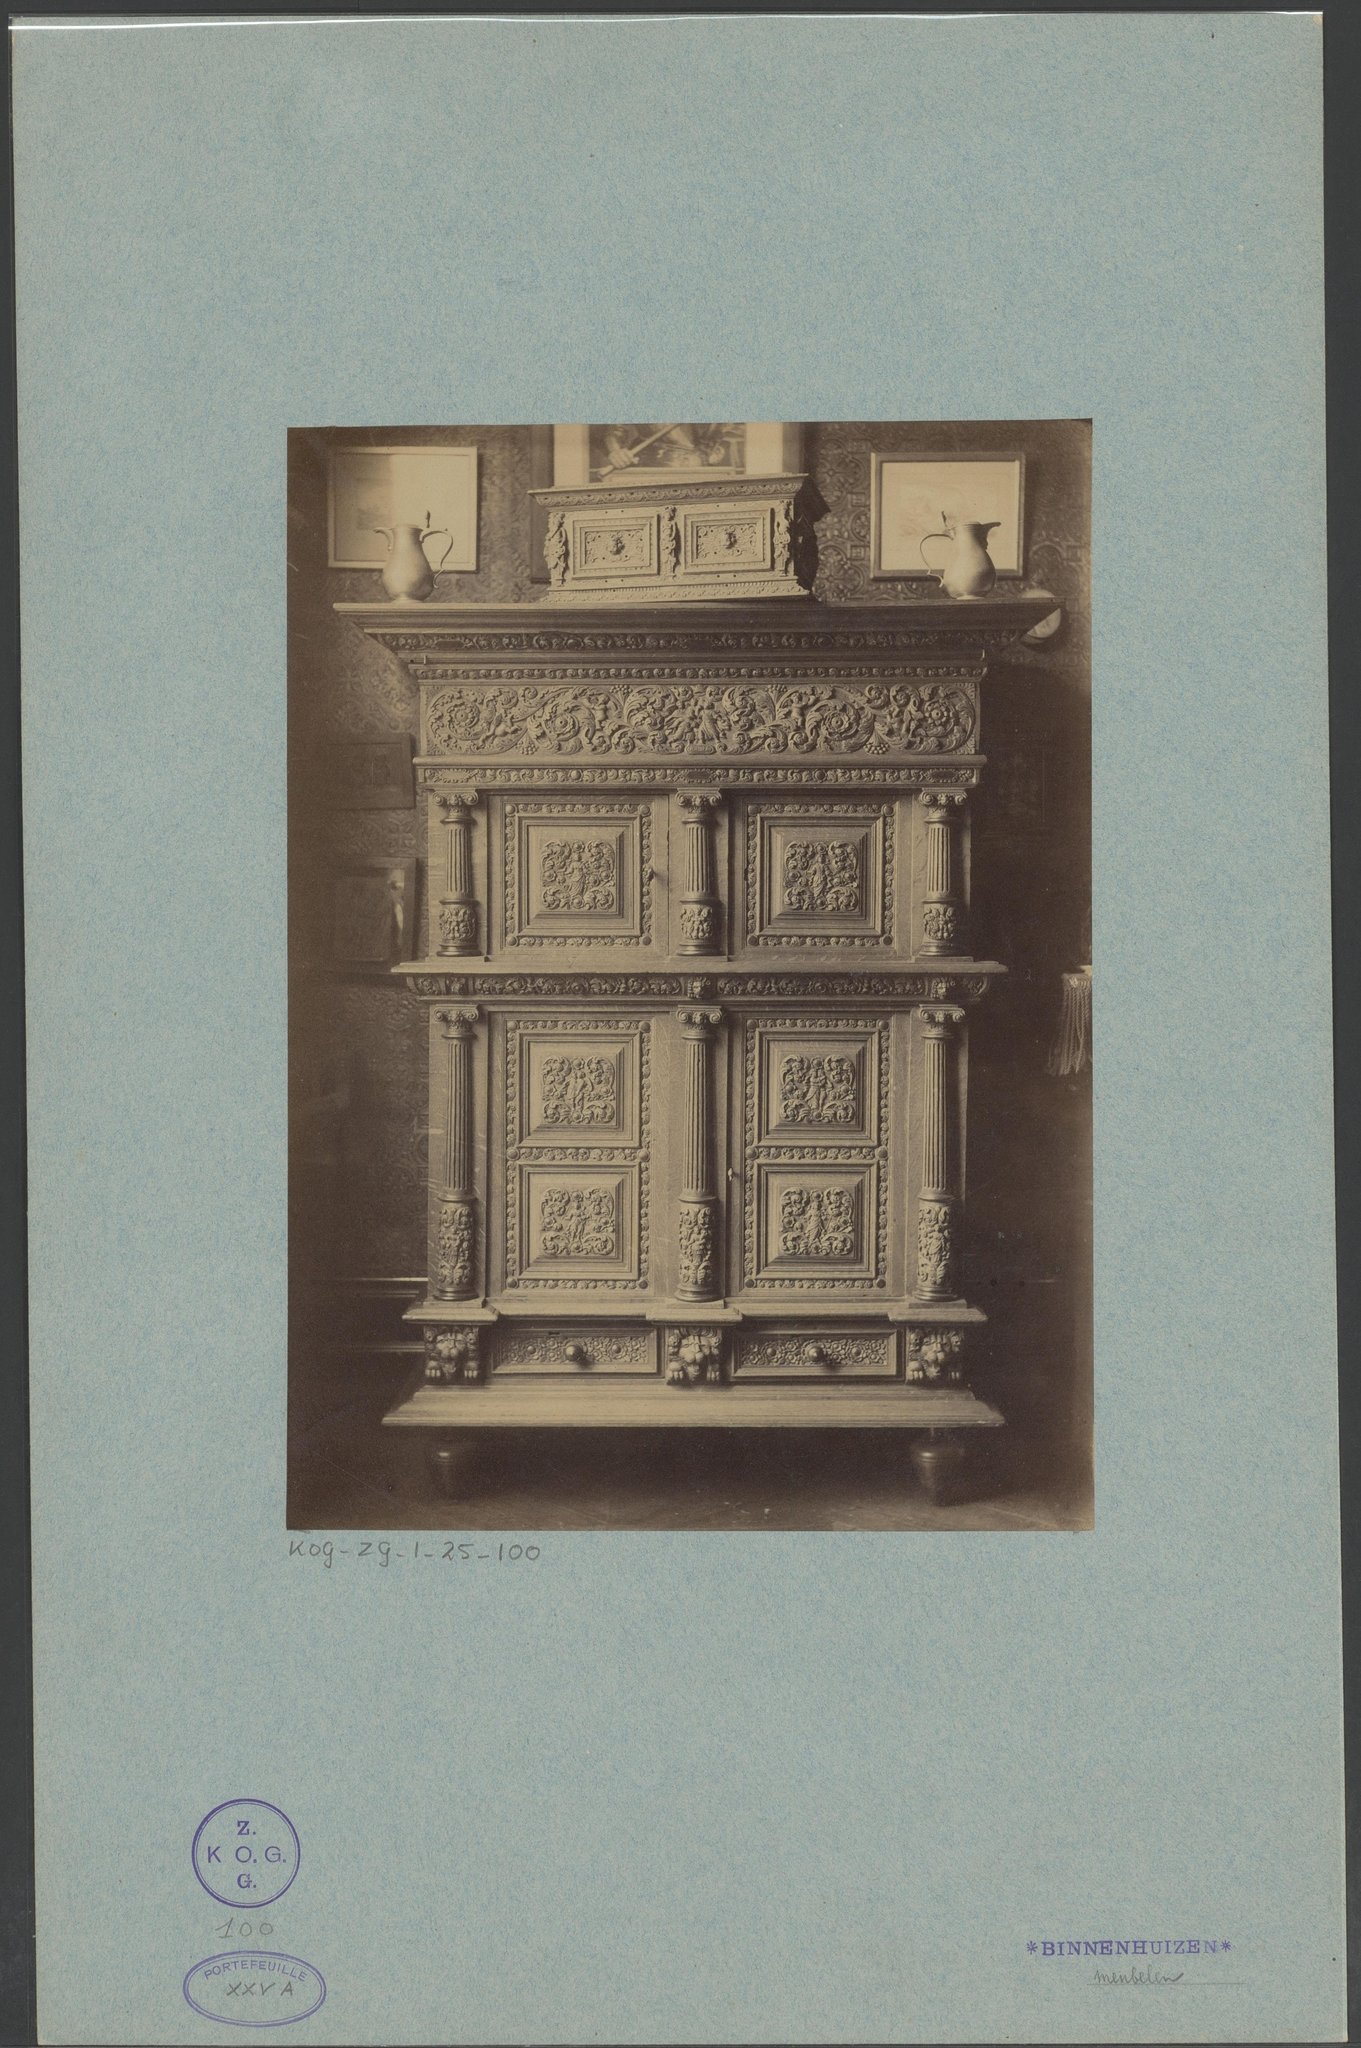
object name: photograph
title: Kast, kist en twee kannen uit de collectie van Daniël Franken Dzn.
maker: Anonymous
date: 1886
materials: cardboard, paper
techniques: albumen print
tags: ornamental cupboard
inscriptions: stamp, stamp, collector's mark: Lugt 1641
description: Onderwerpsrubrieken binnen de Atlas Zeden en Gewoonten: Zeden en Gewoonten in Engeren Zin, De Woning, Binnenhuizen, Meubelen.